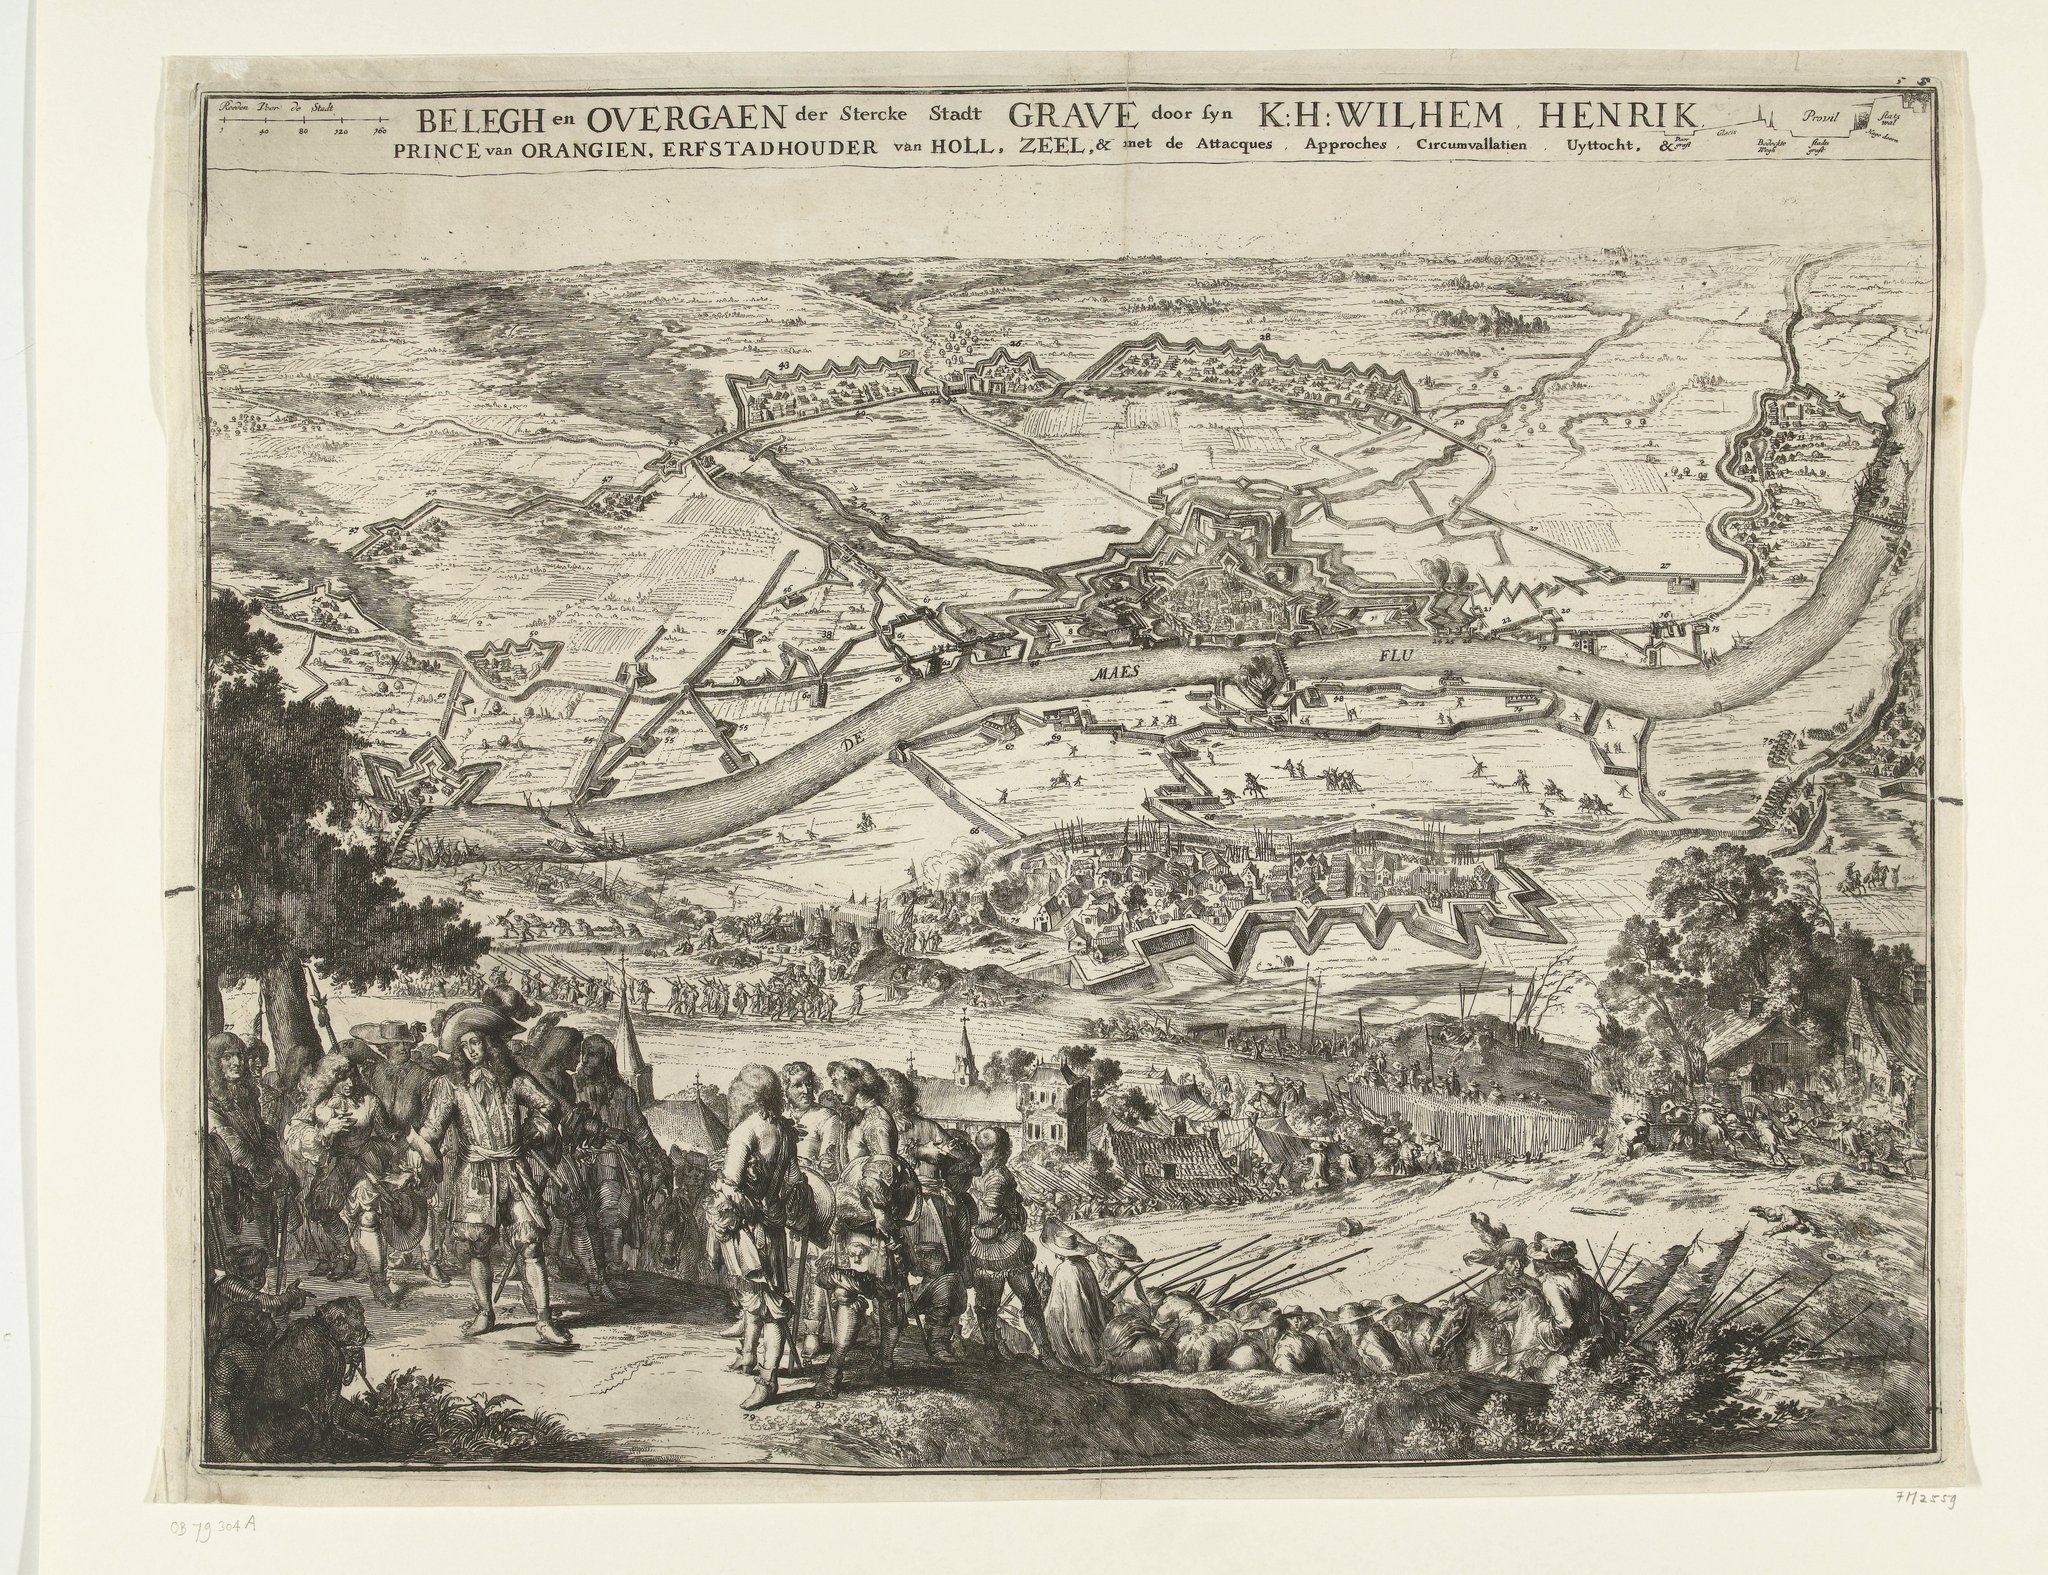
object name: print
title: Beleg en verovering van Grave door Willem III, 1674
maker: romeyn de hooghe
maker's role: draughtsman, goldsmith, painter, print maker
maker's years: 1645-1708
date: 1674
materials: paper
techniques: etching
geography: amsterdam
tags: the hague, william iii (prince of orange and king of england, scotland, and ireland), siege, position war, grave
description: Beleg en verovering van Grave door Willem III, 25 juli tot 29 oktober 1674. Hoofdvoorstelling met een gezicht op de belegerde stad Grave aan de rivier de Maas en de posities van de belegerende troepen. Op de voorgrond Willem III met zijn staf. Uitvoerige voorstelling en beschrijving van deze gebeurtenissen in 2 bladen met 1 grote voorstelling en 6 kleinere voorstellingen. Hierbij ook enkele tekstbladen.